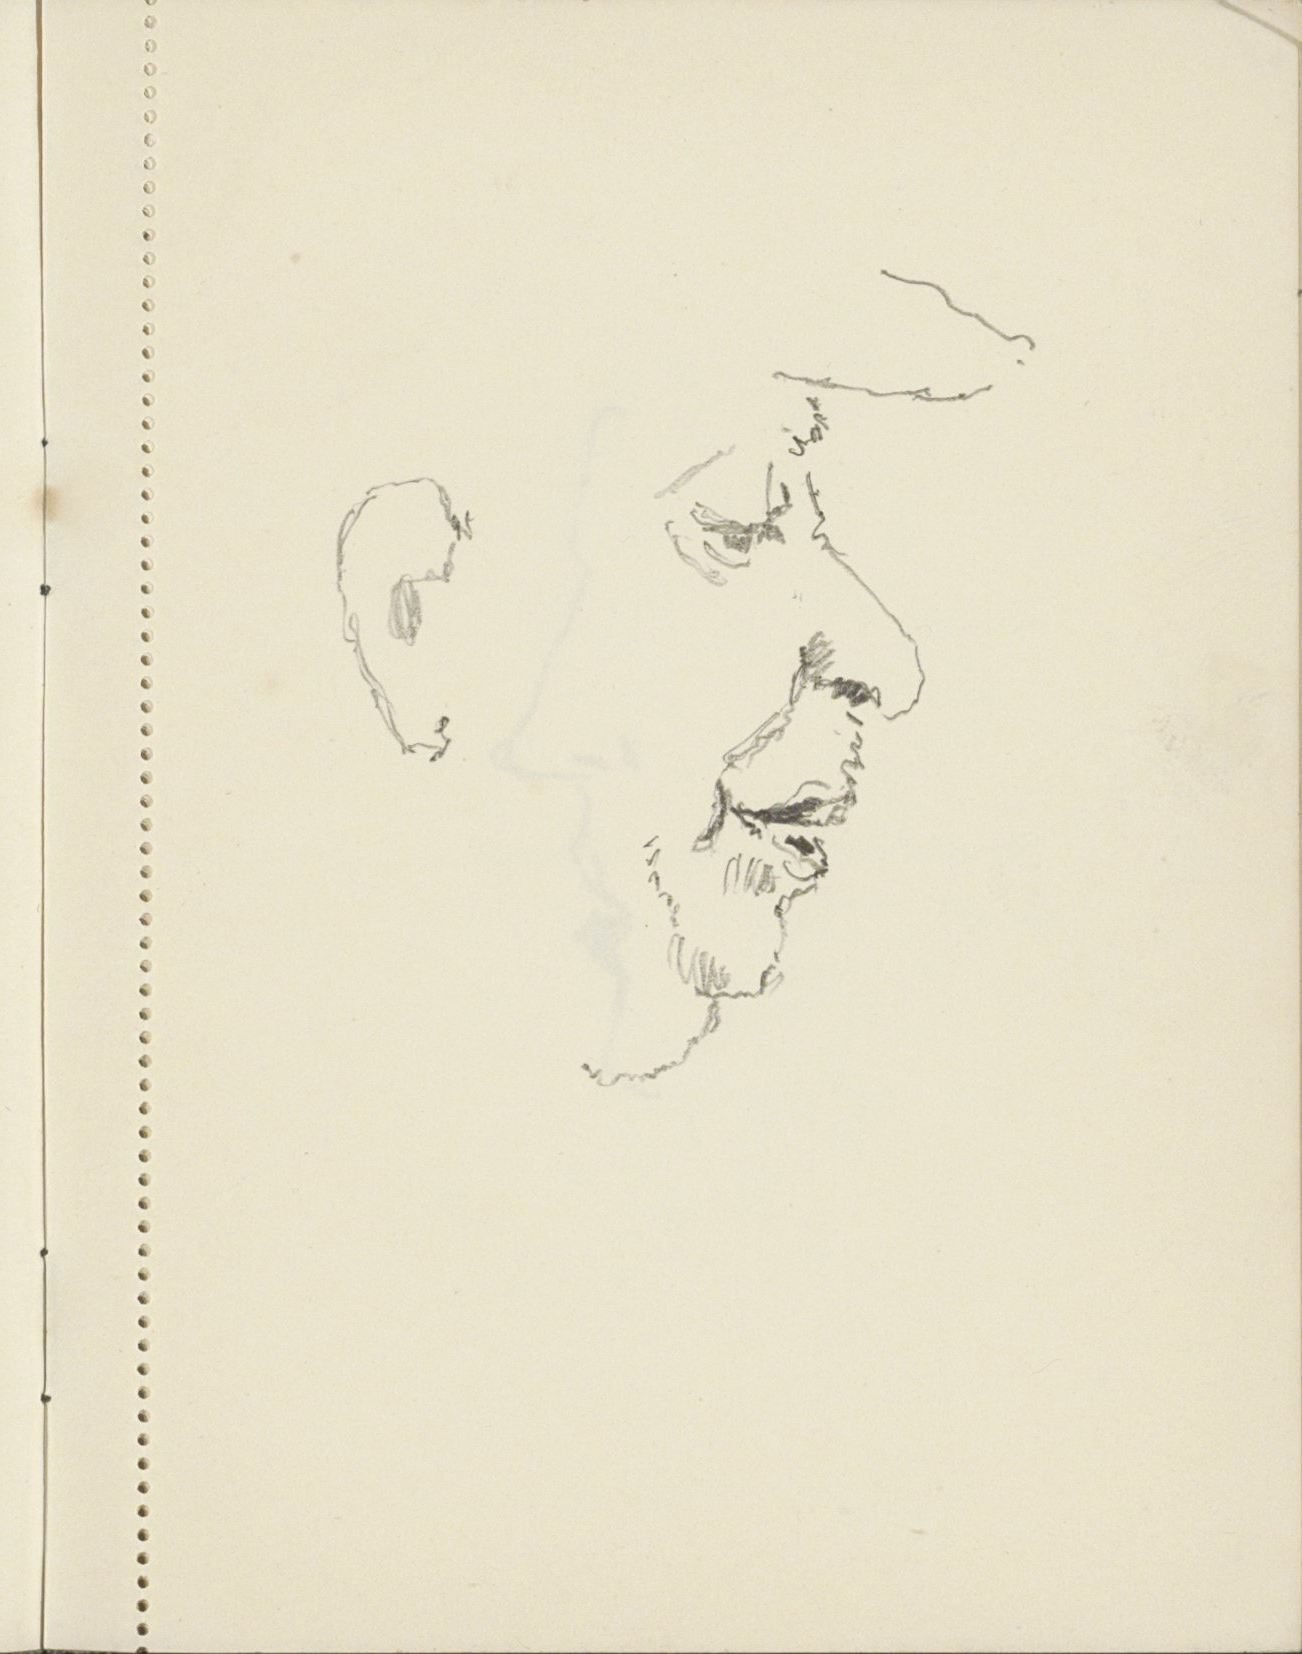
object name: sketchbook leaf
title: Kop van een man met een pet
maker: cornelis vreedenburgh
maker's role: draughtsman, print maker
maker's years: 1880-1946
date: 1890-1946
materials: paper, pencil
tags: head (human) (+ right side visible; right - (r. hand, r. foot, etc.))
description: Blad 30 recto uit een schetsboek met 71 bladen.